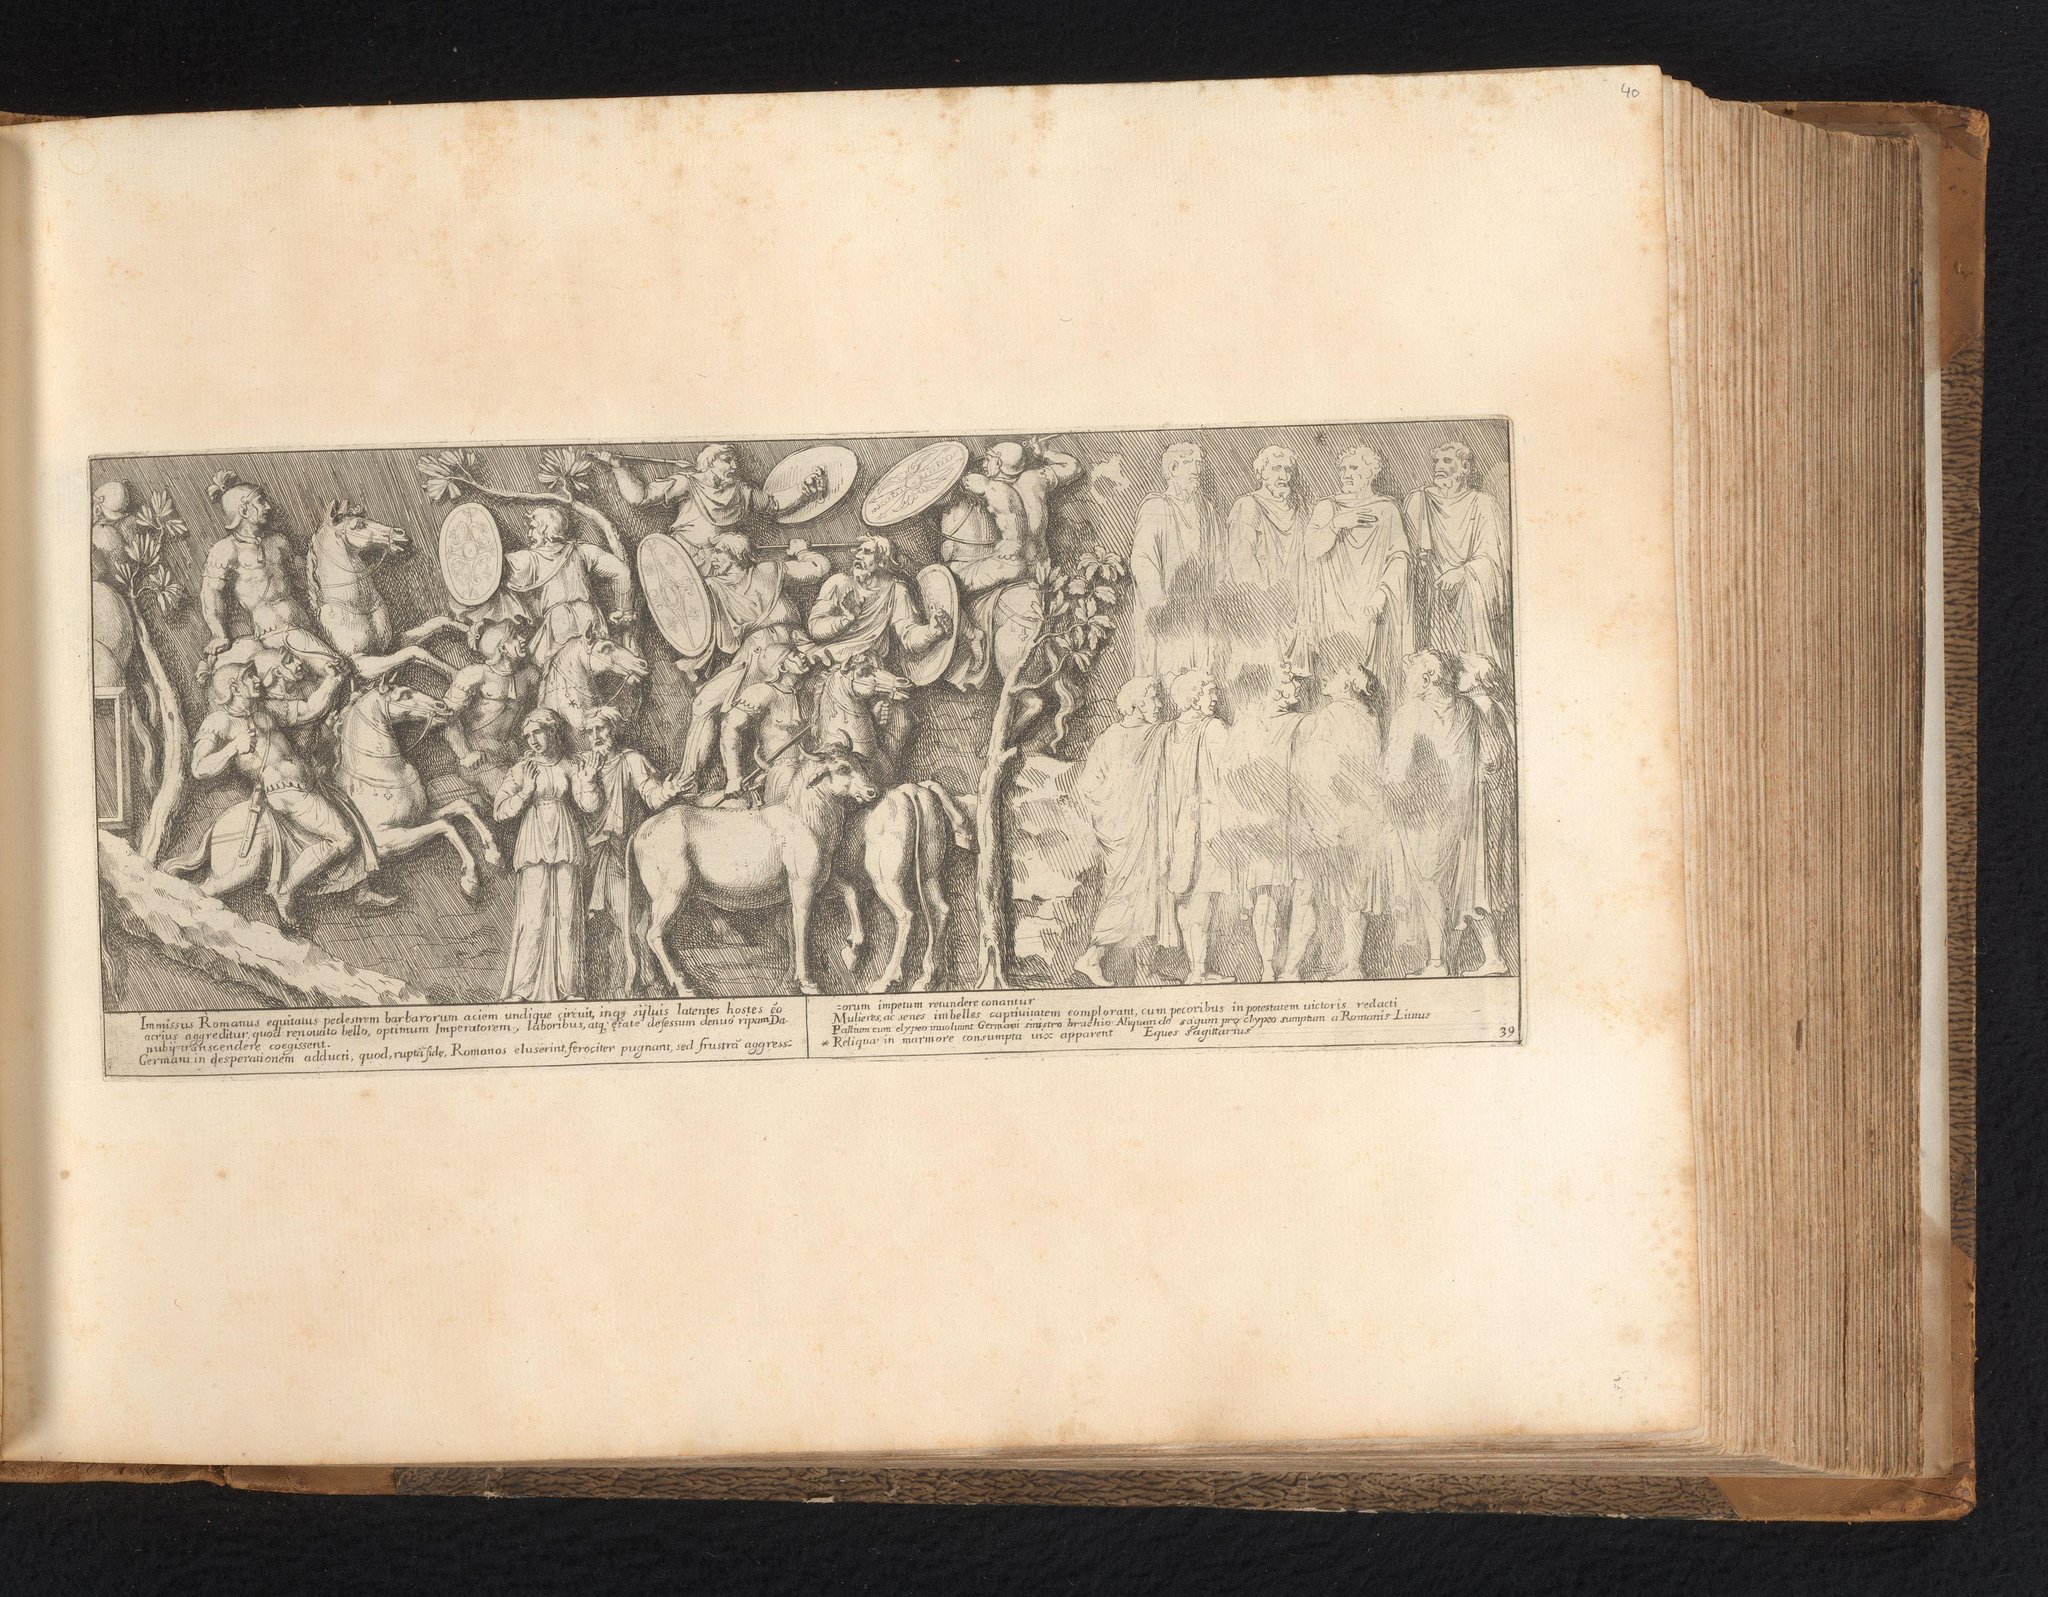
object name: album leaf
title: Columna Antoniniana Marci Aurelii Antonini Augusti rebus gestis insignis (...)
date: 1672-1675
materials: paper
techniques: etching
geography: rome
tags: triumphal column with helical friezes, piece of sculpture, reproduction of a piece of sculpture, the soldier; the soldier's life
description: Detail van het spiraalvormige gebeeldhouwde fries op de Zuil van Marcus Aurelius te Rome. Het fries toont de oorlog tussen het Romeinse leger van keizer Marcus Aurelius en de Germaanse stammen der Marcomannen en Quaden en de oorlog tegen de Sarmaten die vanuit het huidige Iran Hongarije waren binnengevallen. Tekst in de ondermarge. Prent maakt deel uit van een album.